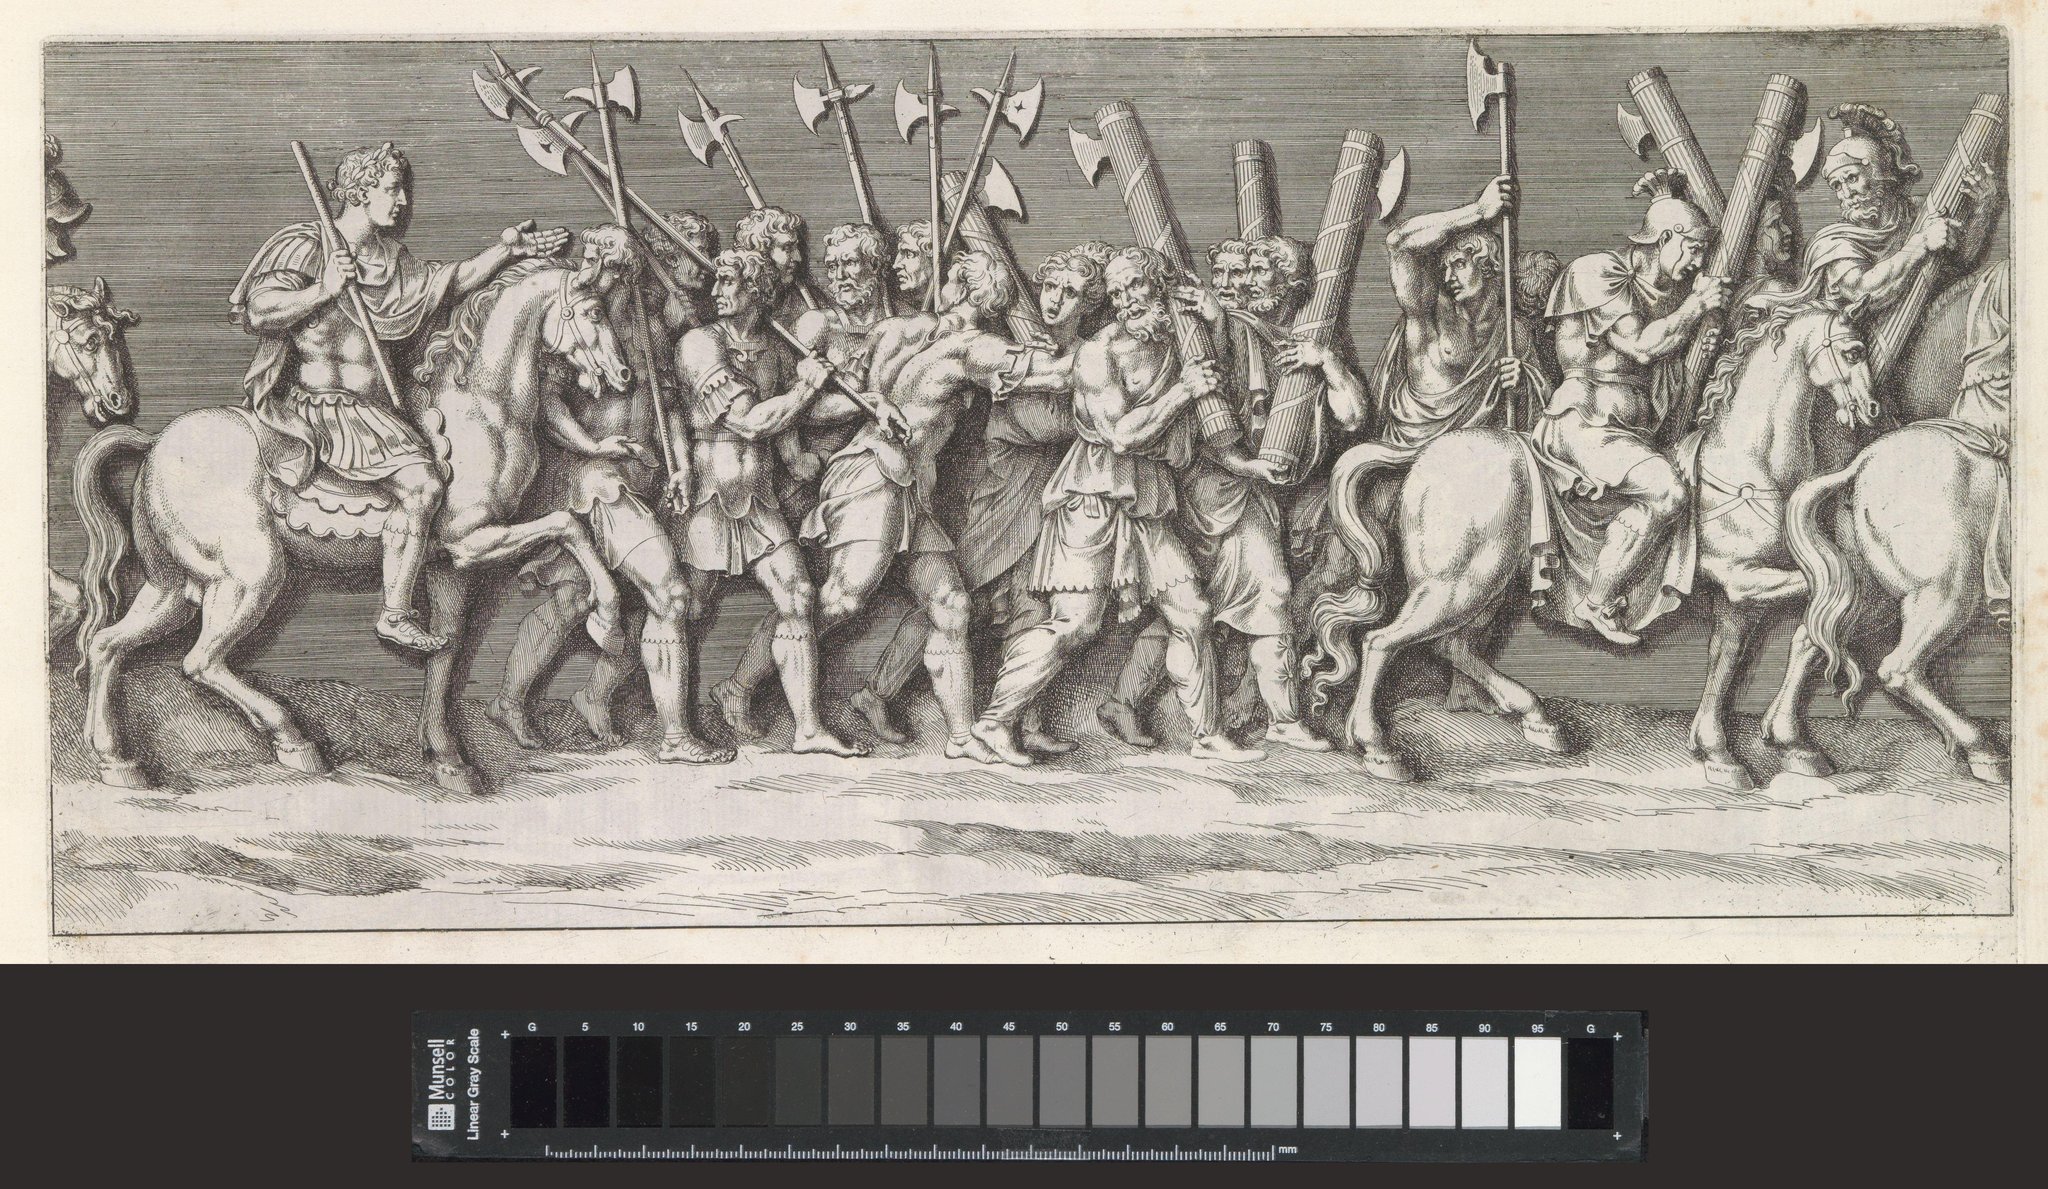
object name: album leaf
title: Stucwerk in de Sala degli Stucchi in Palazzo del Te te Mantua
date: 1680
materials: paper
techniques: etching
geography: mantua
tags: triumphal entry and public reception, pageant, 'entrée solennelle', 'joyeuse entrée', weapons, military parade, pageant, the soldier; the soldier's life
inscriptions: number: ‘16’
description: Prent maakt deel uit van een reeks van 25 prenten (+ titelprent) naar het stucwerk door Giulio Romano en Francesco Primaticcio in de Sala degli Stucchi in Palazzo del Te te Mantua.